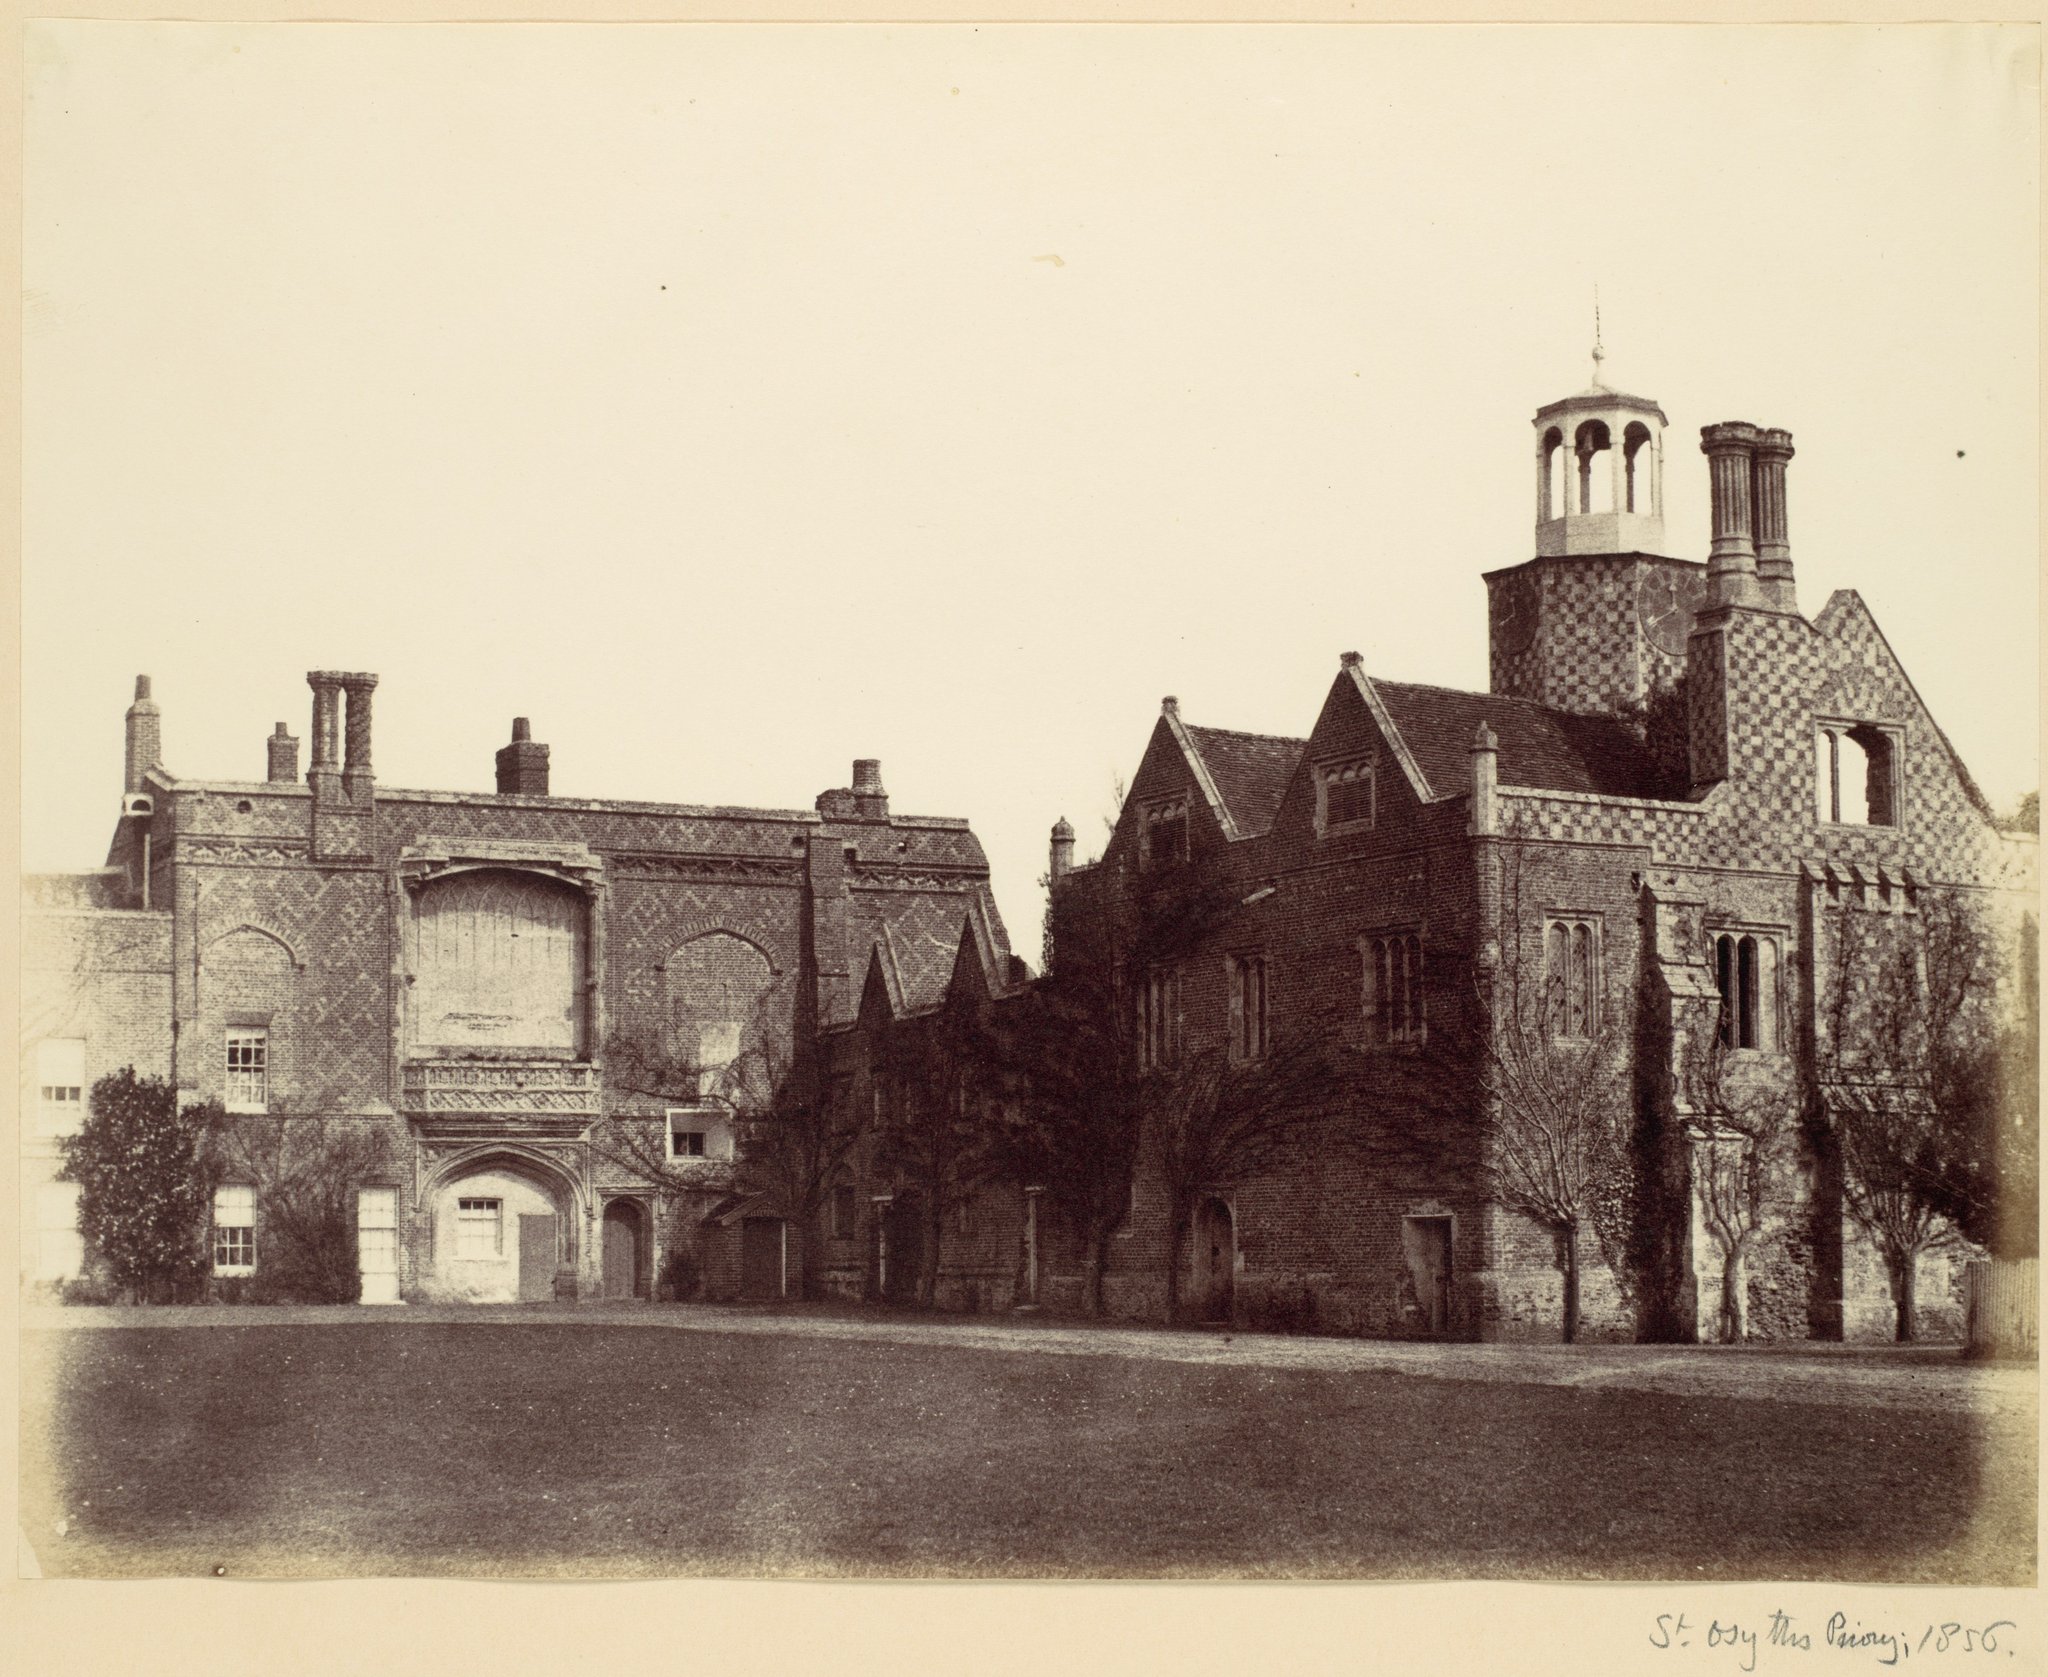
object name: photograph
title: St. Osyth's Priory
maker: alfred capel cure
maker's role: artist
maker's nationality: british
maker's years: 1826-1896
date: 1856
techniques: albumen silver print, paper negative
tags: architecture,buildings